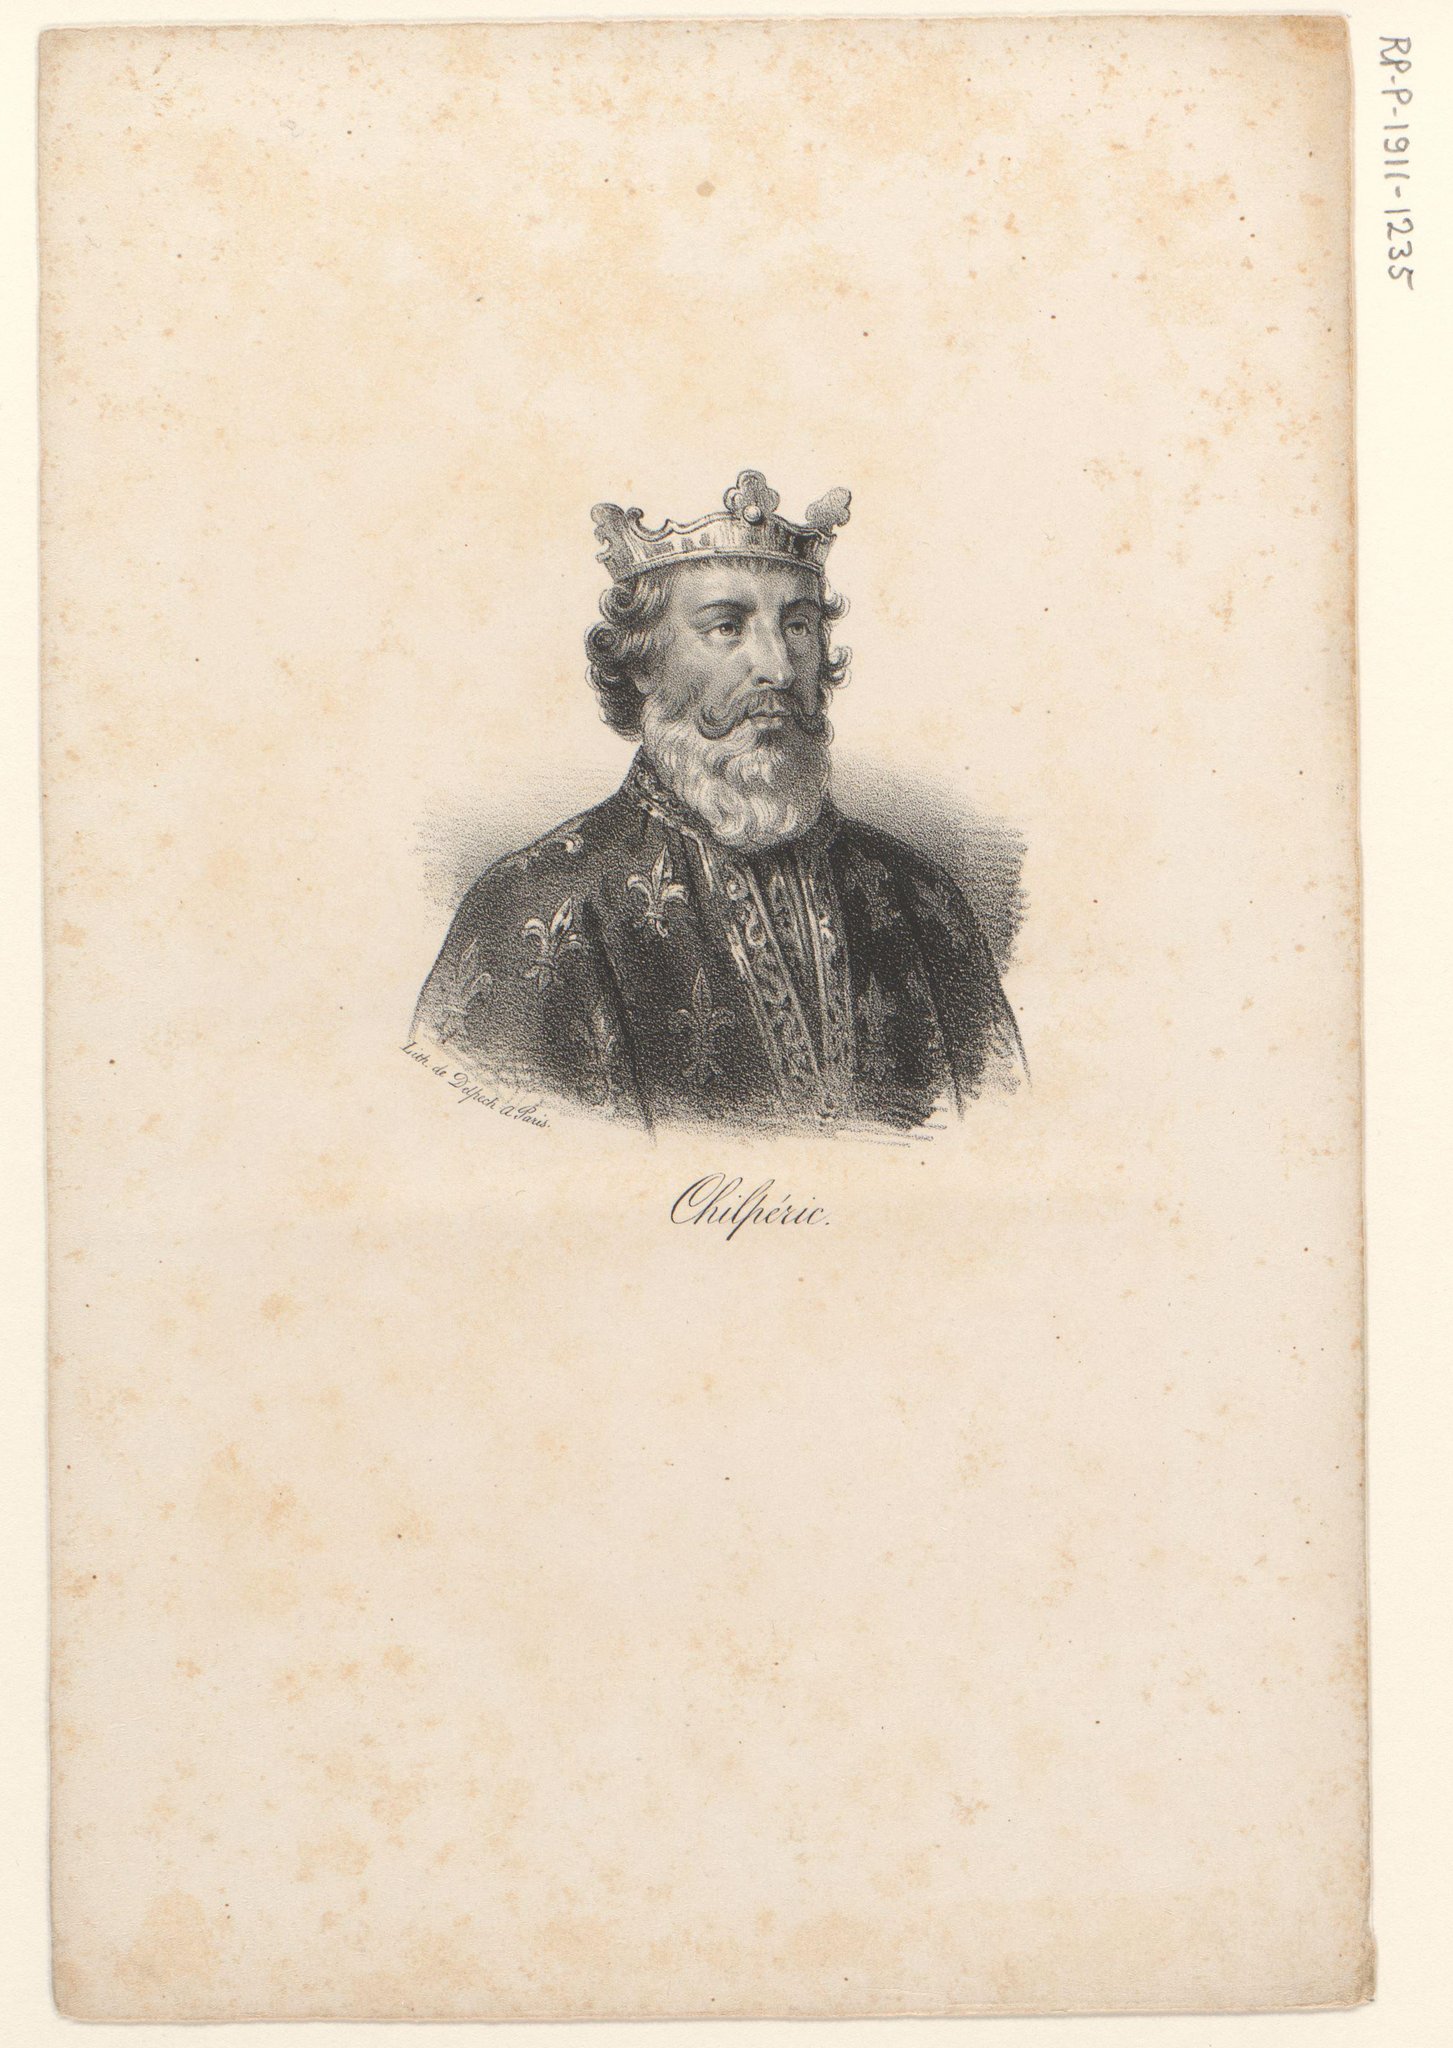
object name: print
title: Chilpéric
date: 1818-1842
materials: paper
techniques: lithograph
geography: paris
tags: historical persons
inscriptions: collector's mark: Lugt 2228a